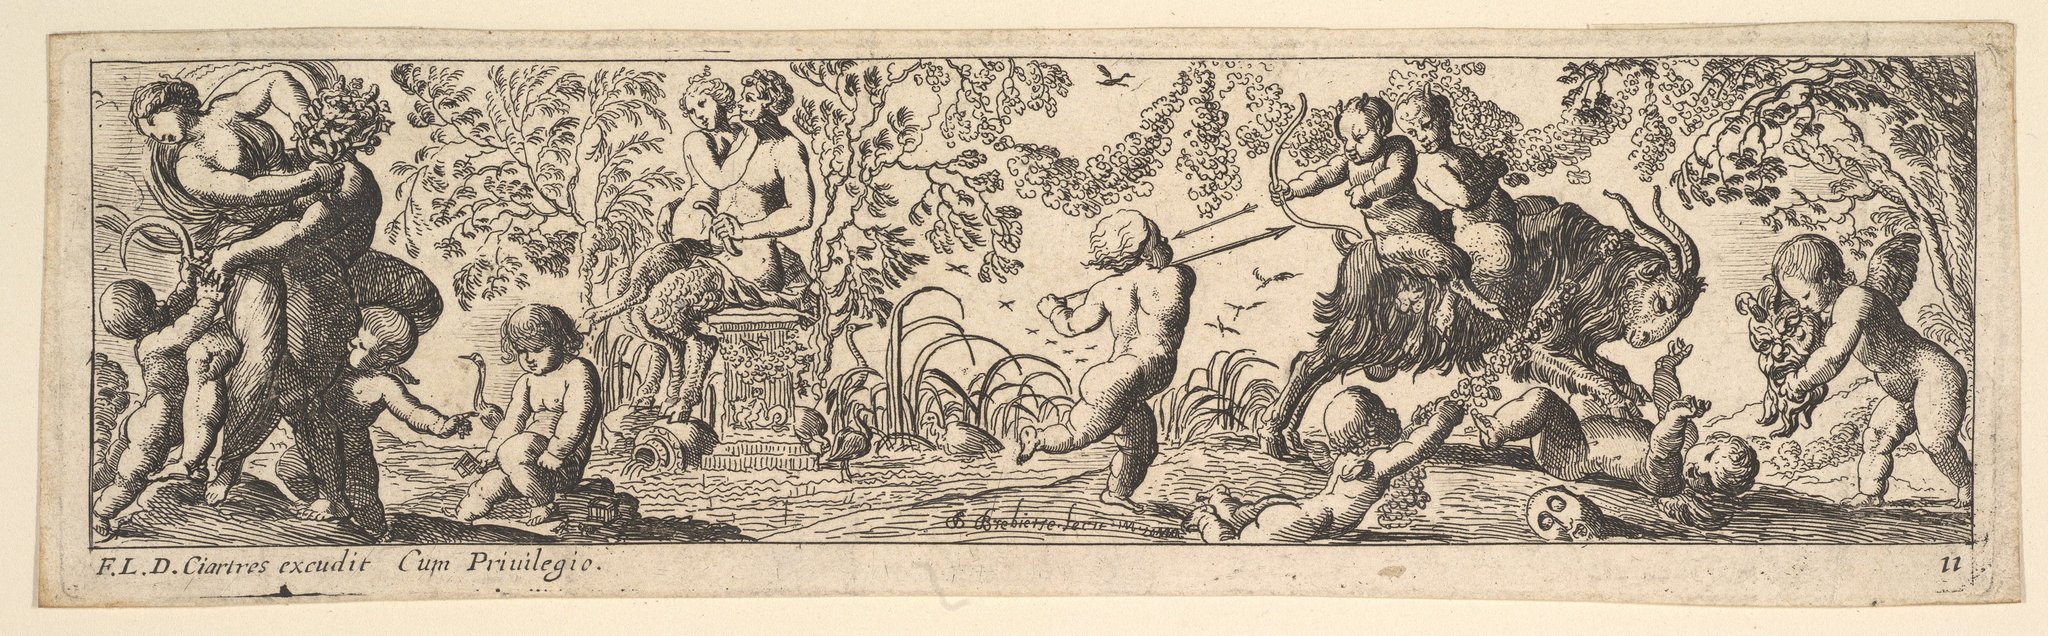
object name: print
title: Children's Games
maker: pierre brebiette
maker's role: artist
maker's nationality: french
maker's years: 1598-1642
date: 1615-1642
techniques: etching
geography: france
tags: children,women,playing,putti,satyrs,goats